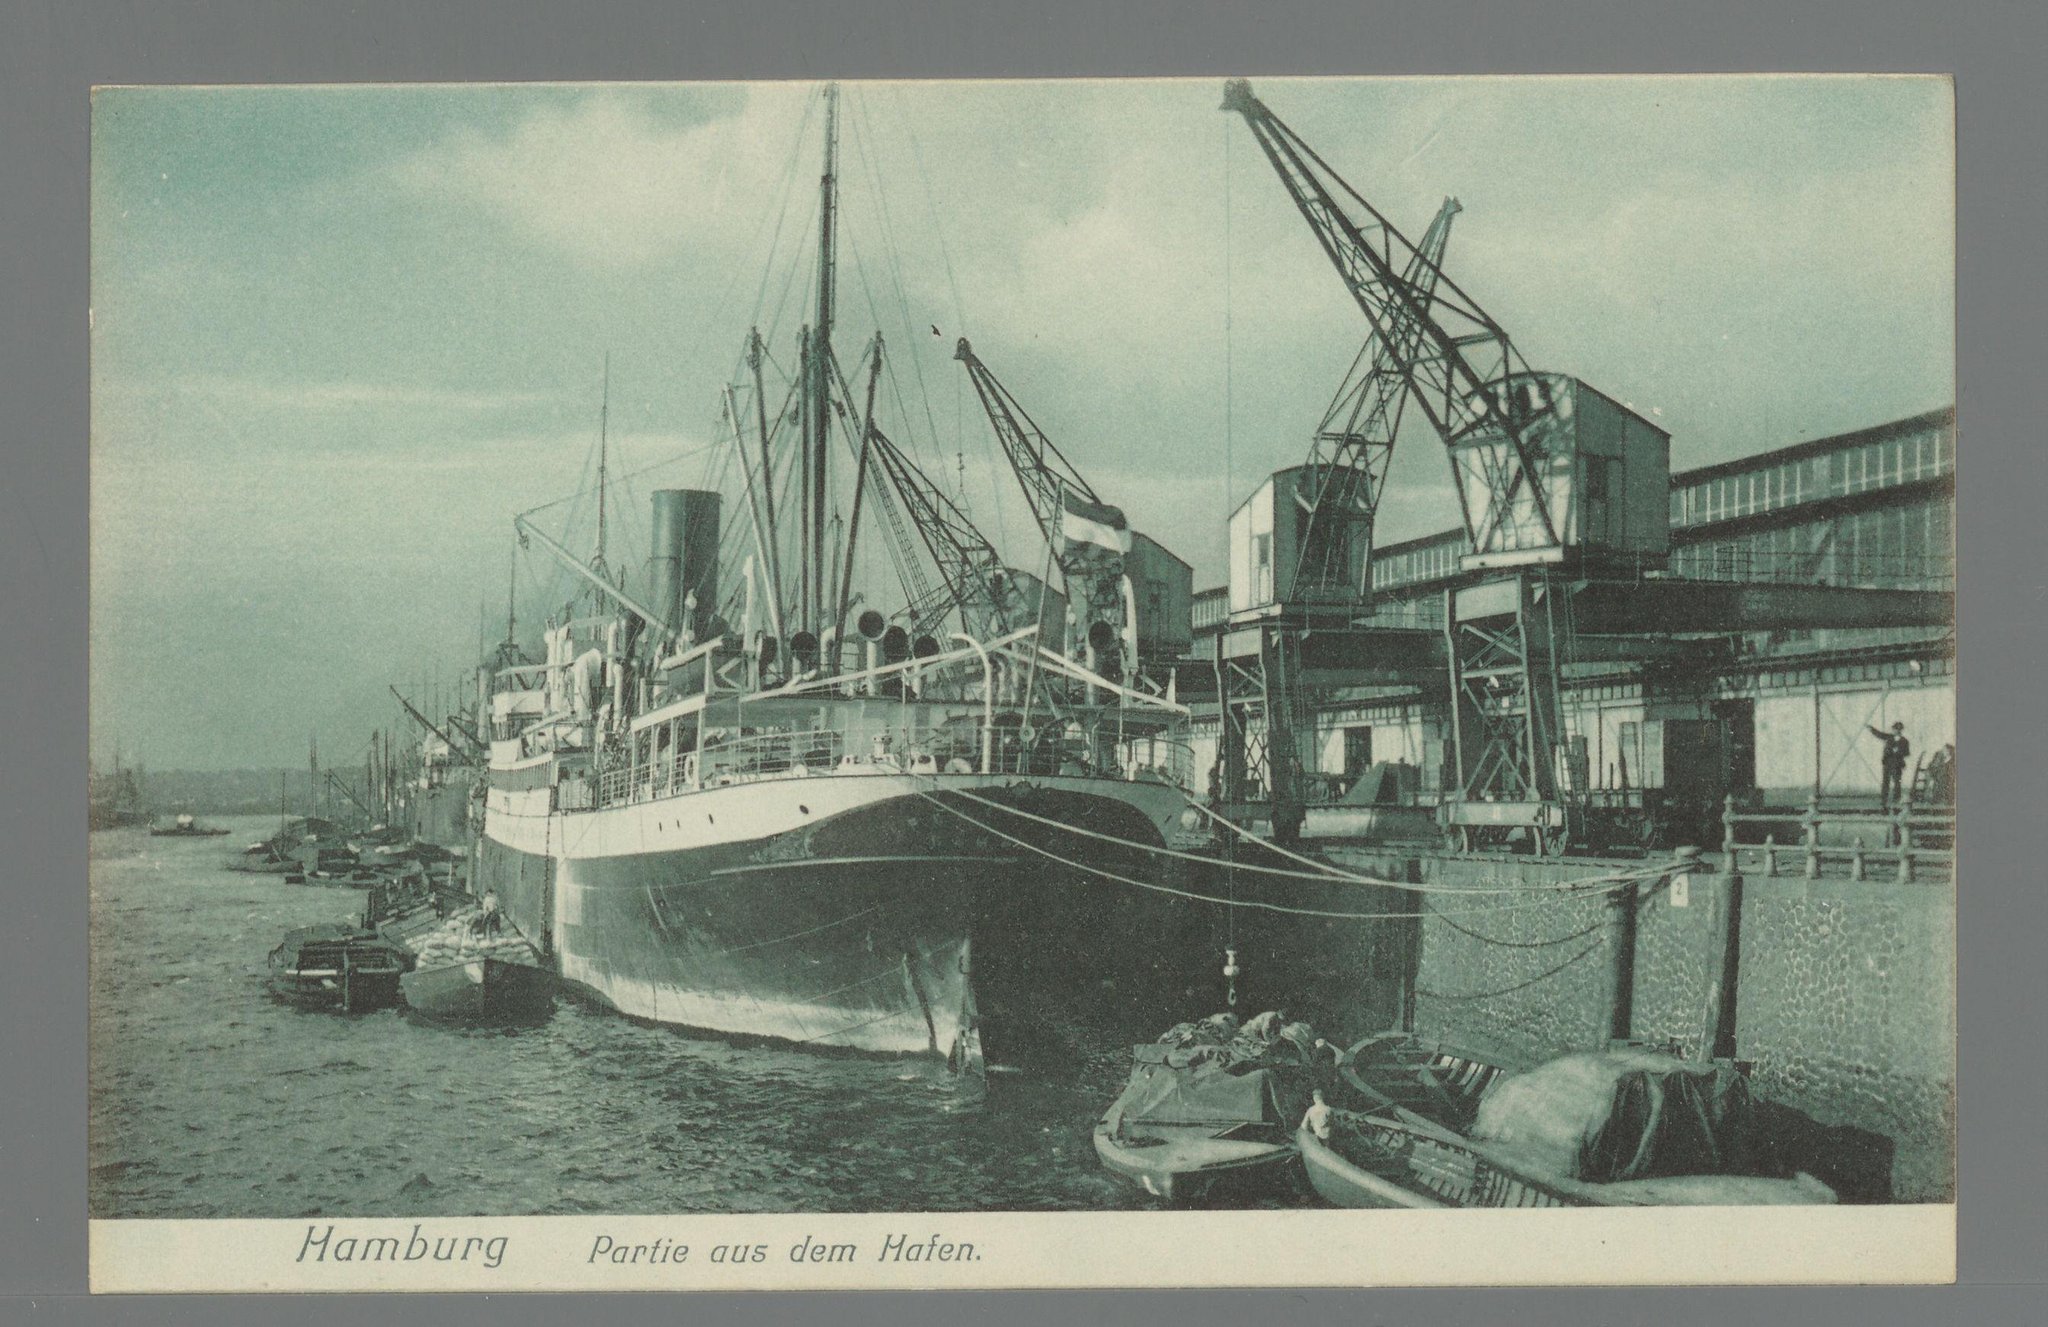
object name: ansichtkaart, prentbriefkaart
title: Hamburg. Partie aus dem Hafen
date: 1905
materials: cardboard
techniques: photograph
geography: hamburg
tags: harbour, steamship, motorship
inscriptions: date